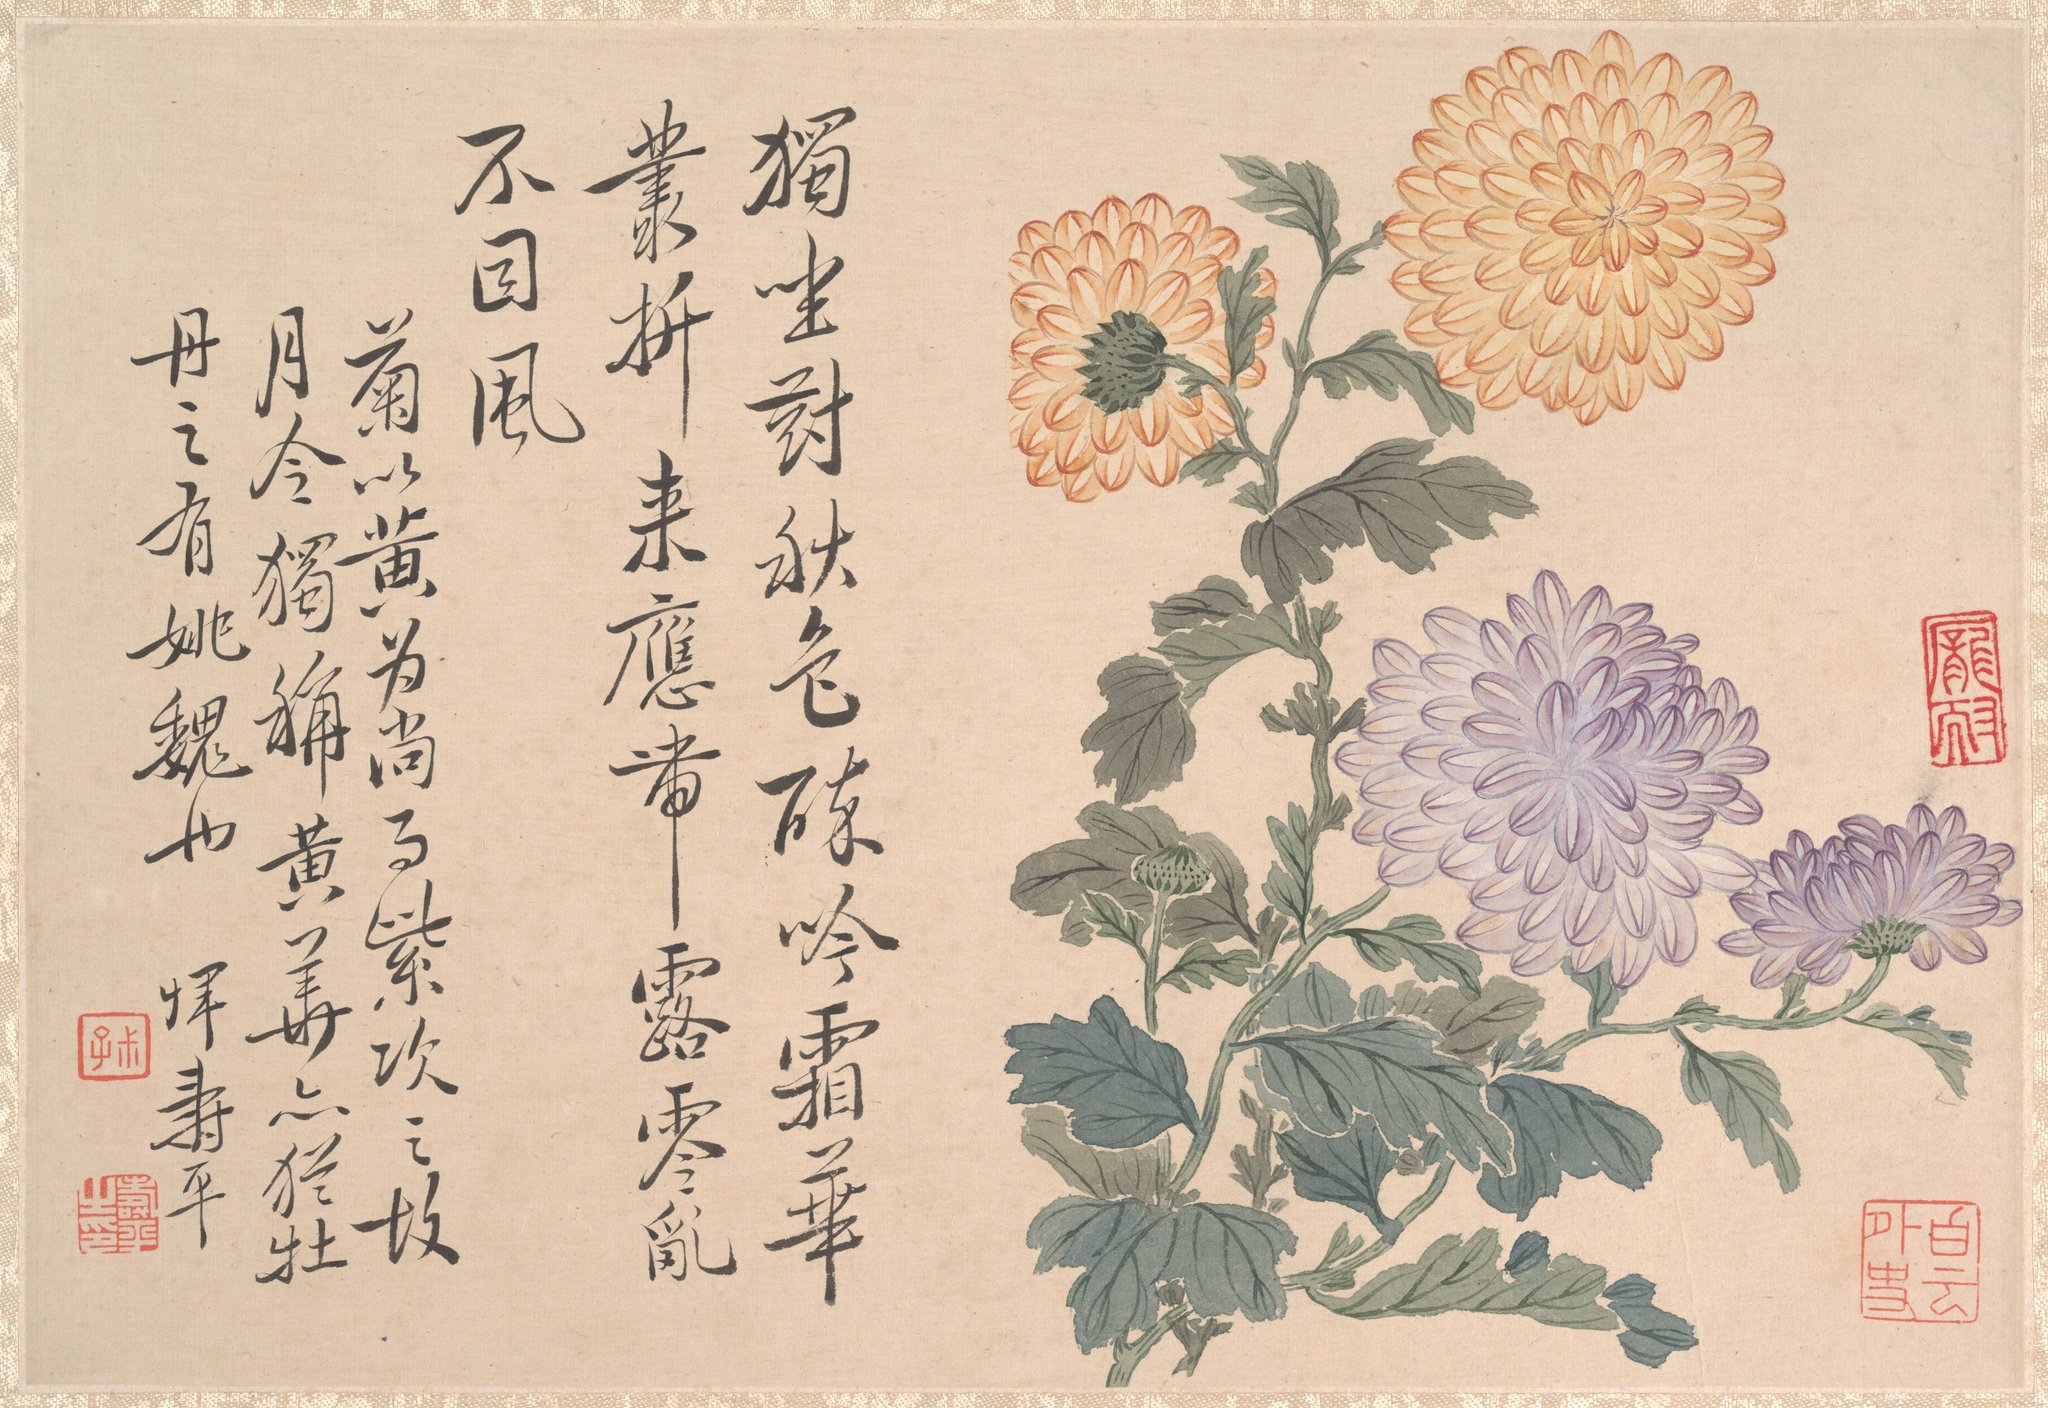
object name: album leaf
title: Chrysanthemums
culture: chinese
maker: unidentified artist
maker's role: artist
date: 1644-1911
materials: ink, paper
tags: flowers